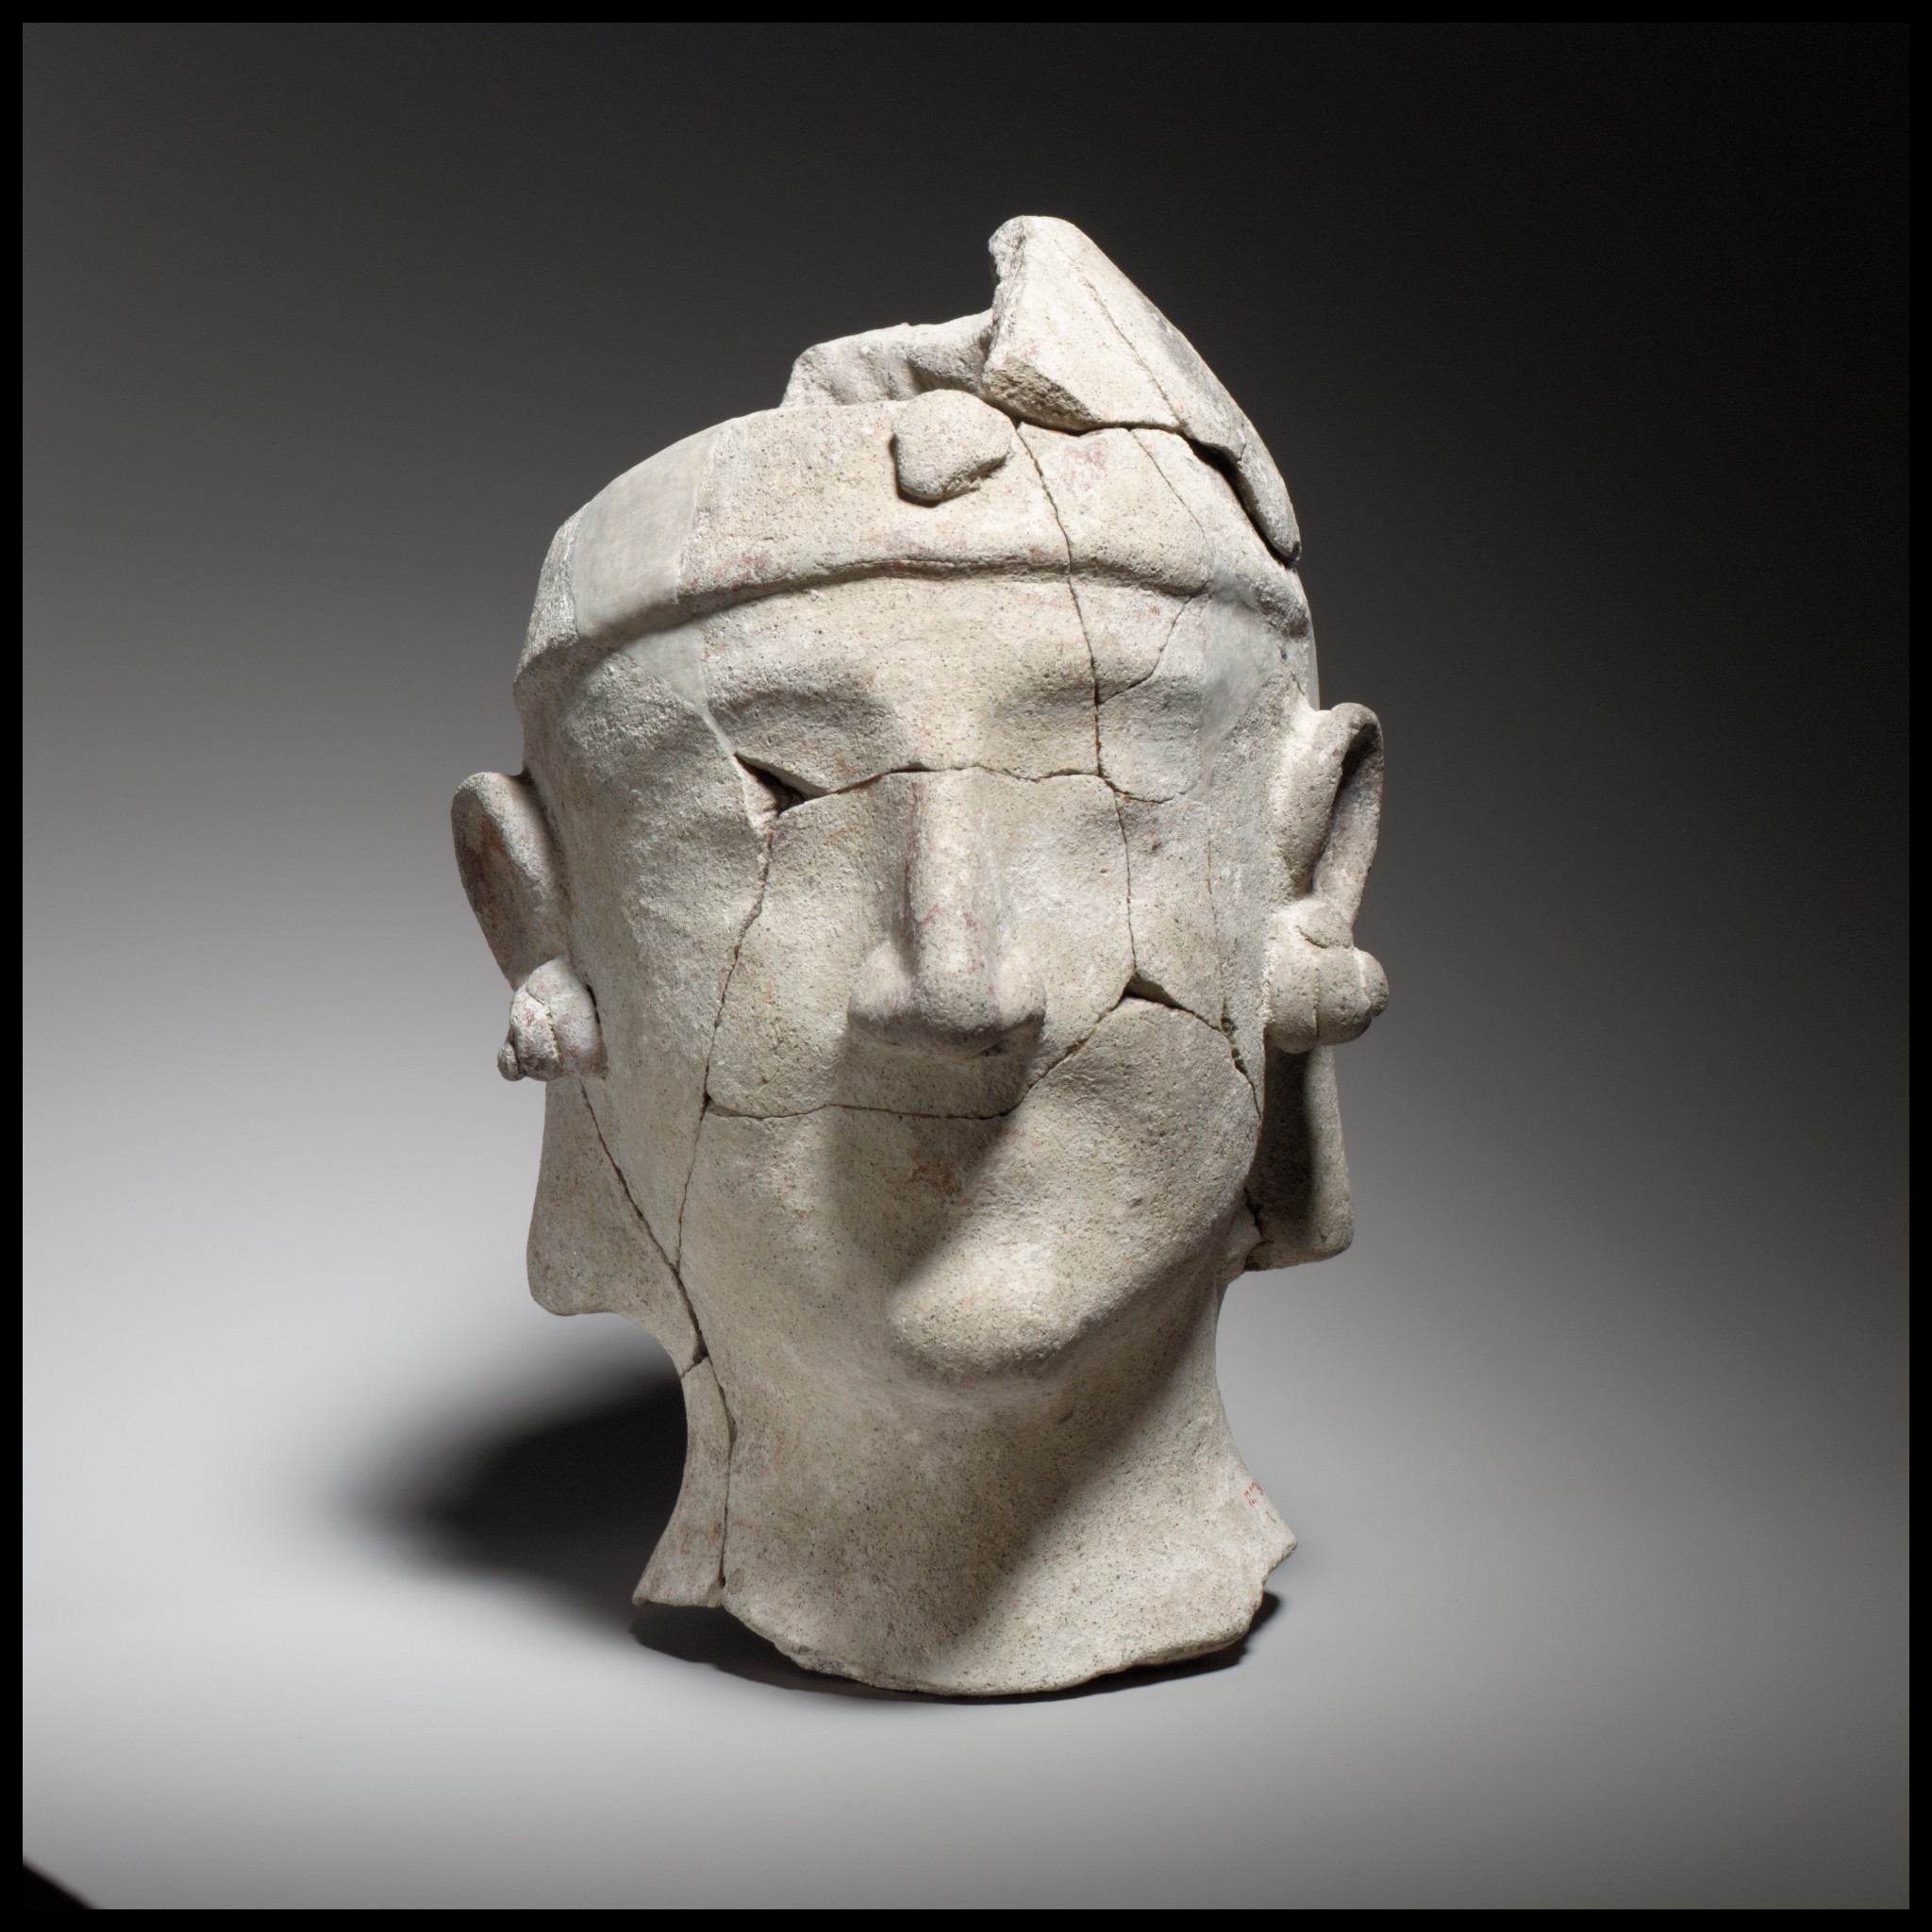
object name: head of a man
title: Beardless male head wearing a helmet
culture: cypriot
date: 600-480 BCE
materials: terracotta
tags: helmets,heads,men